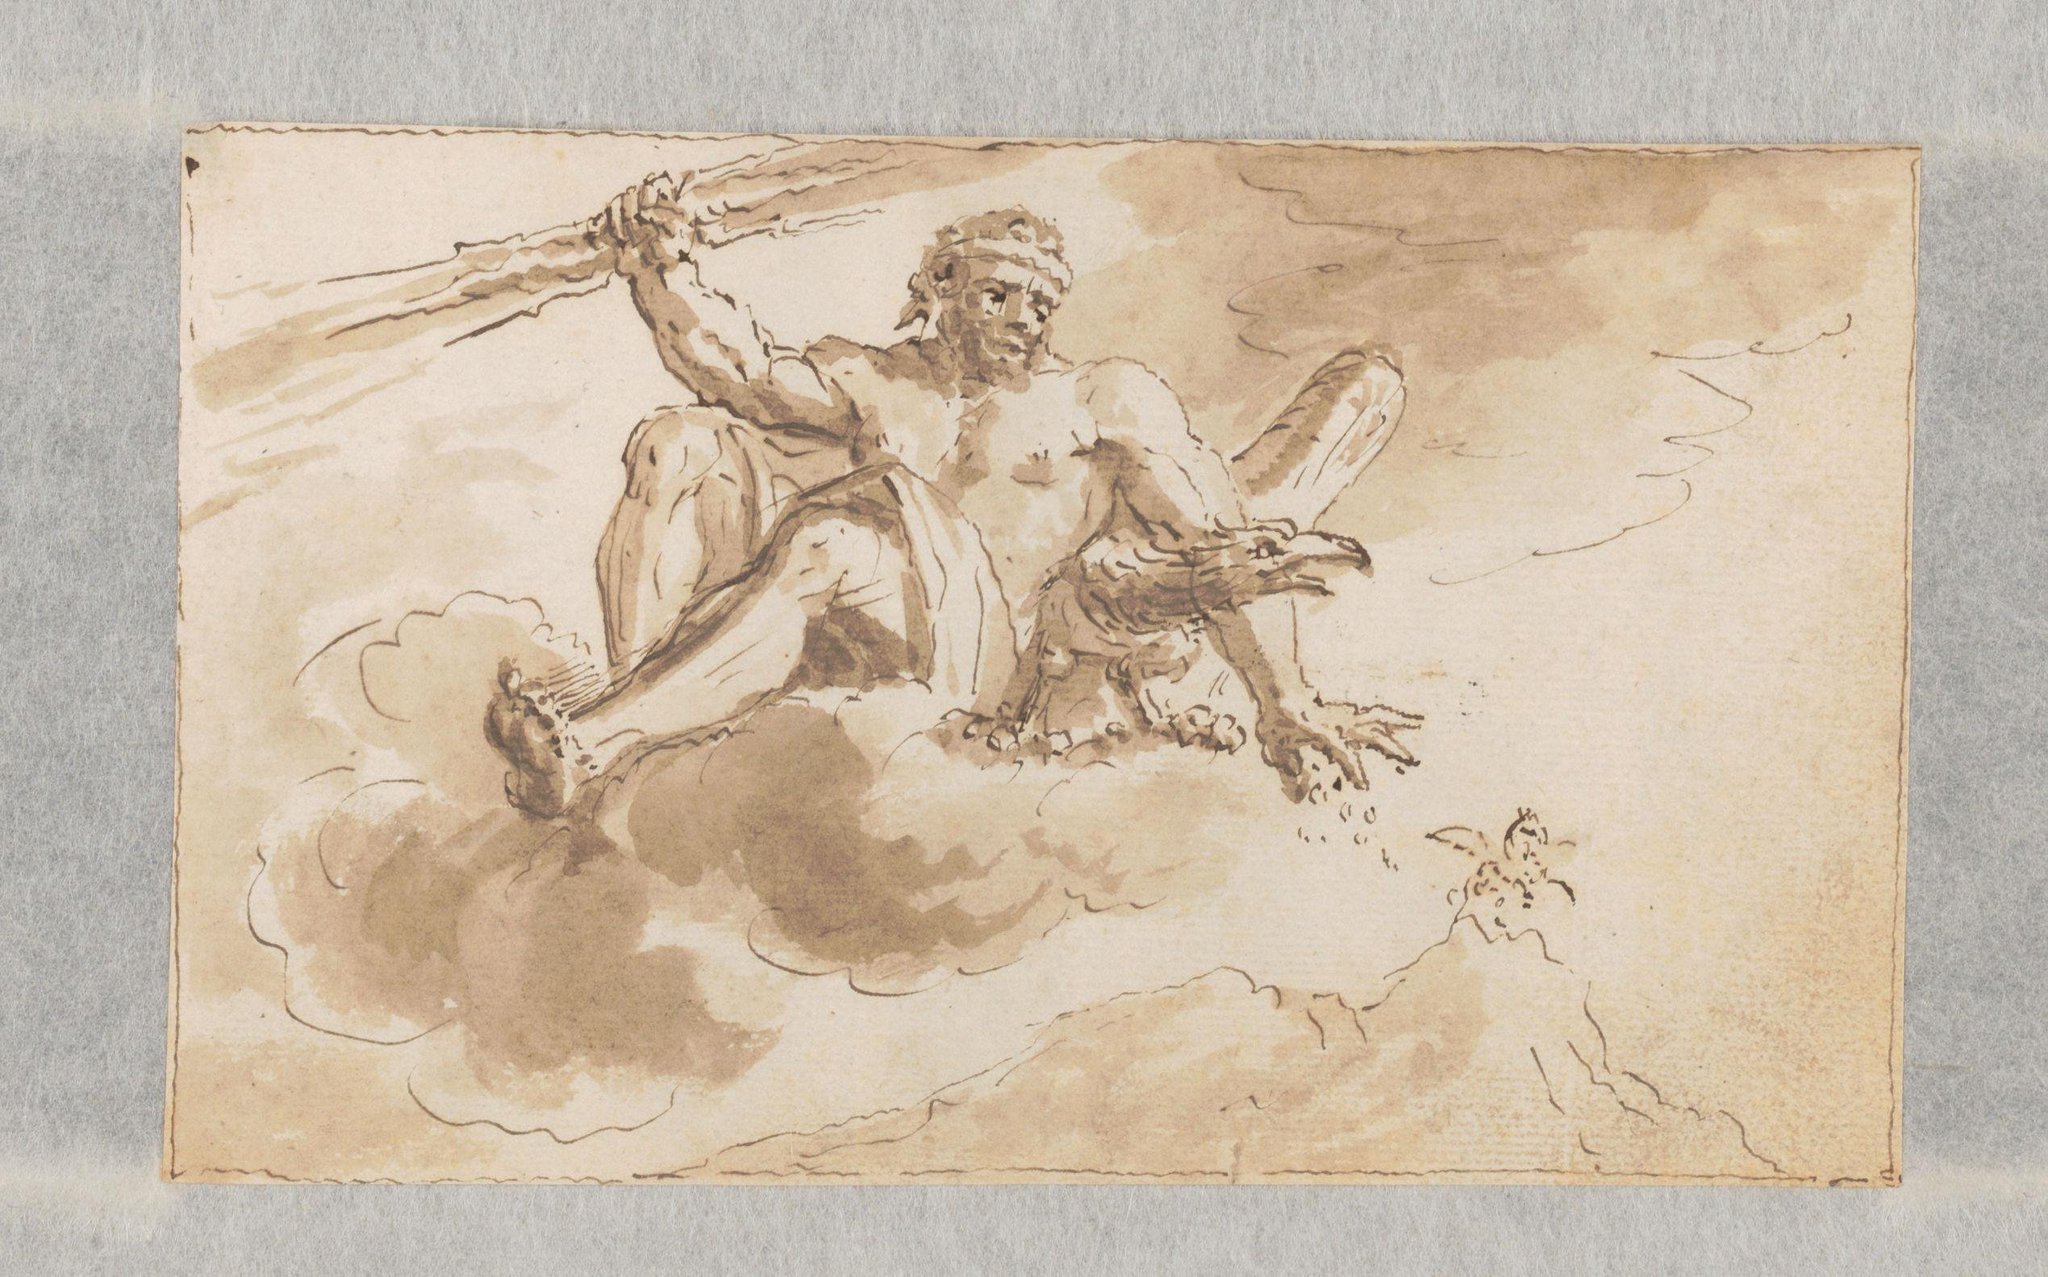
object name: drawing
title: Jupiter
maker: romeyn de hooghe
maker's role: draughtsman, goldsmith, painter, print maker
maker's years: 1645-1708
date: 1702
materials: ink, paper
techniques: brush, pen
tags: pegasus, the winged horse, (story of) jupiter (zeus)